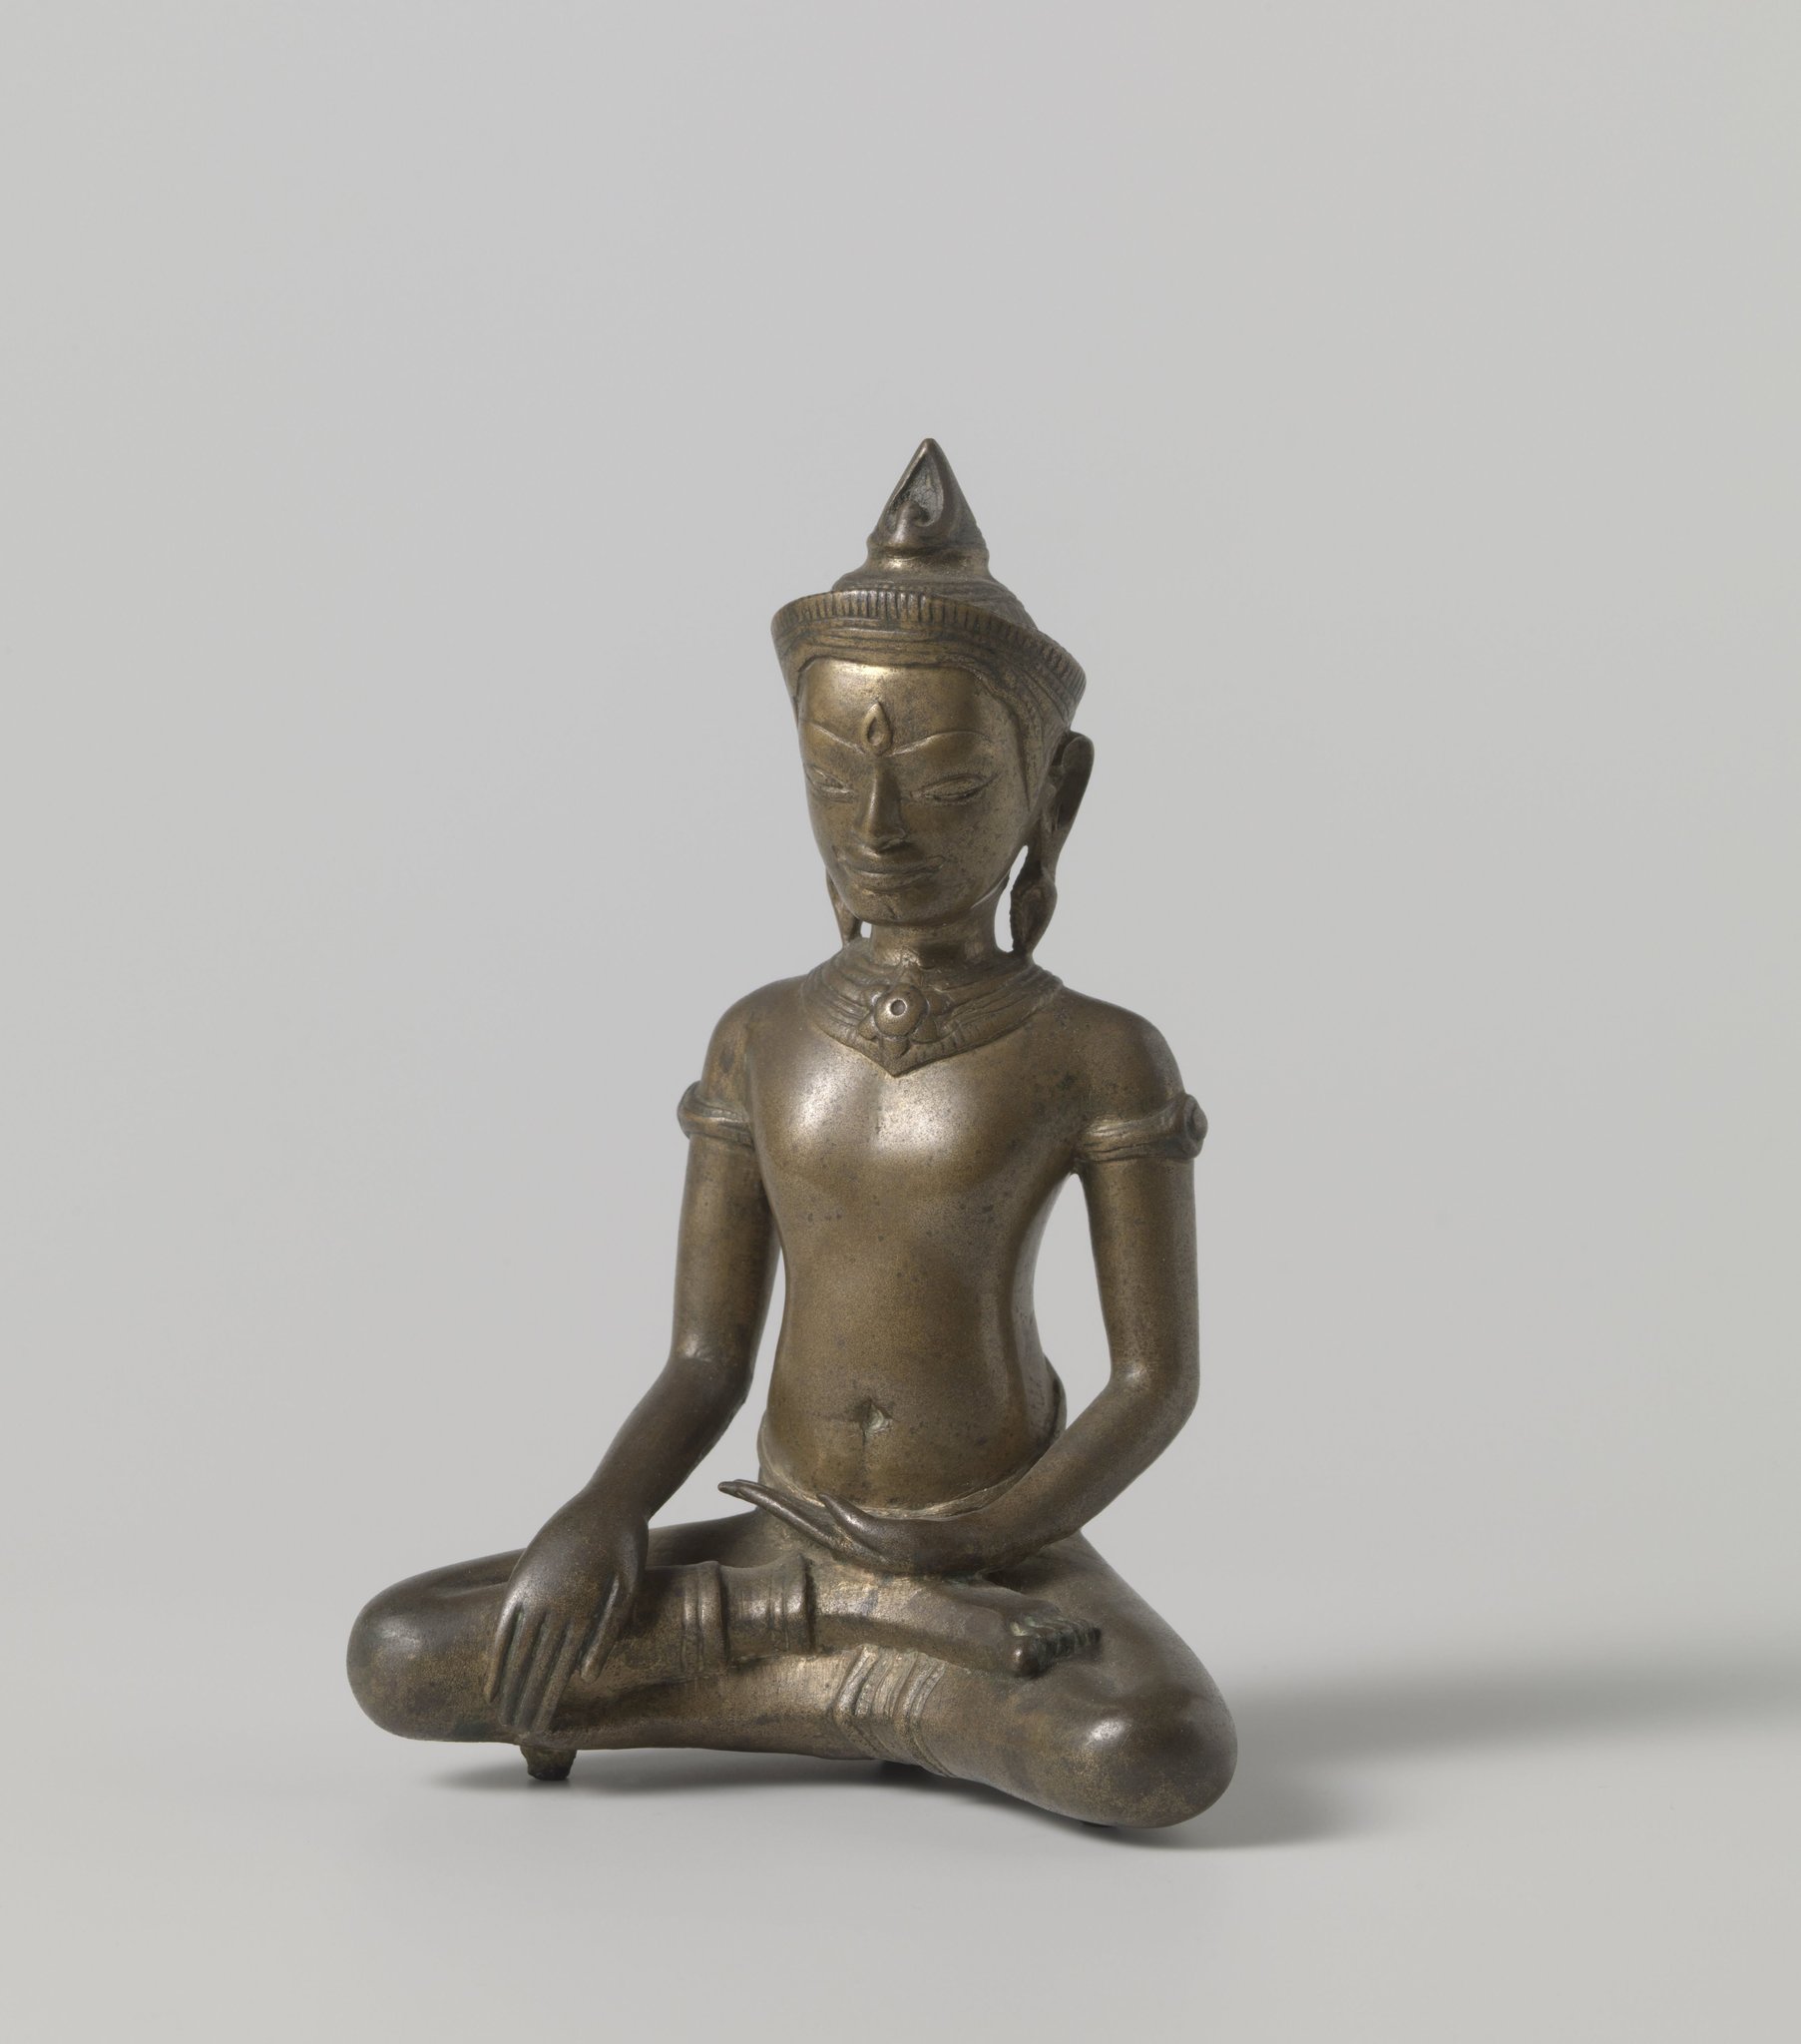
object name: boeddha kop, boeddha beeld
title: Zittende Boeddha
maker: Anonymous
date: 1300-1400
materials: bronze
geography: cambodia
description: Zittende Boeddha met gekruiste benen; rechterhand rust op het rechteronderbeen (bhumisparsamudra).